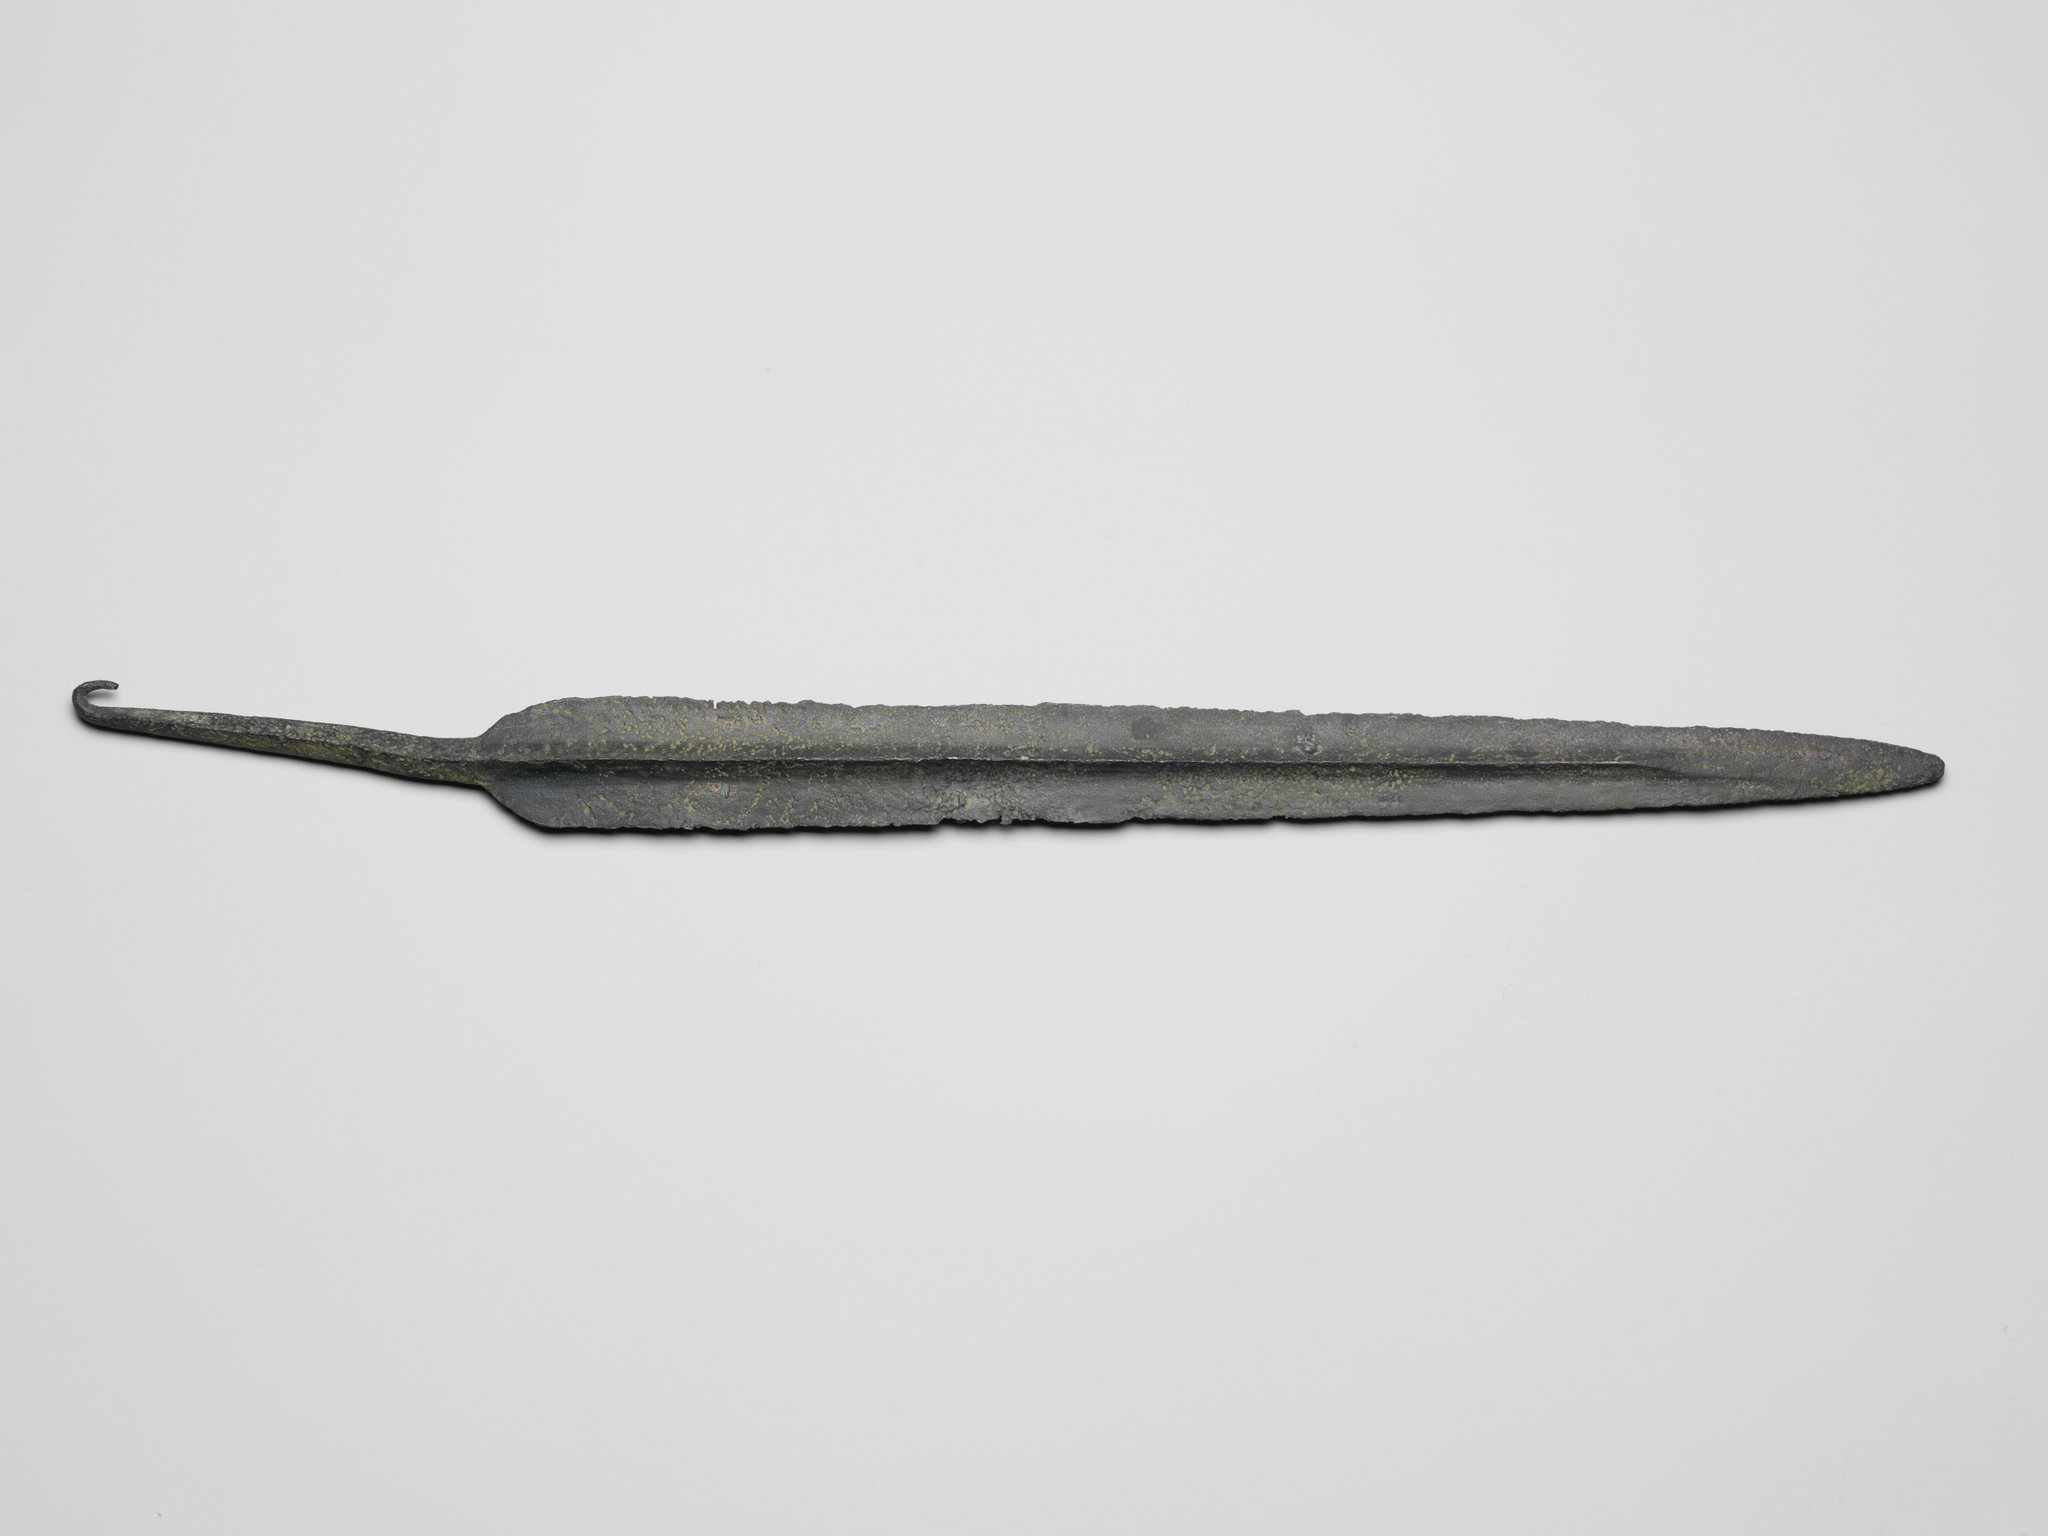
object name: dagger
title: Copper alloy spearhead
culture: cypriot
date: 2500-2000 BCE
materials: bronze